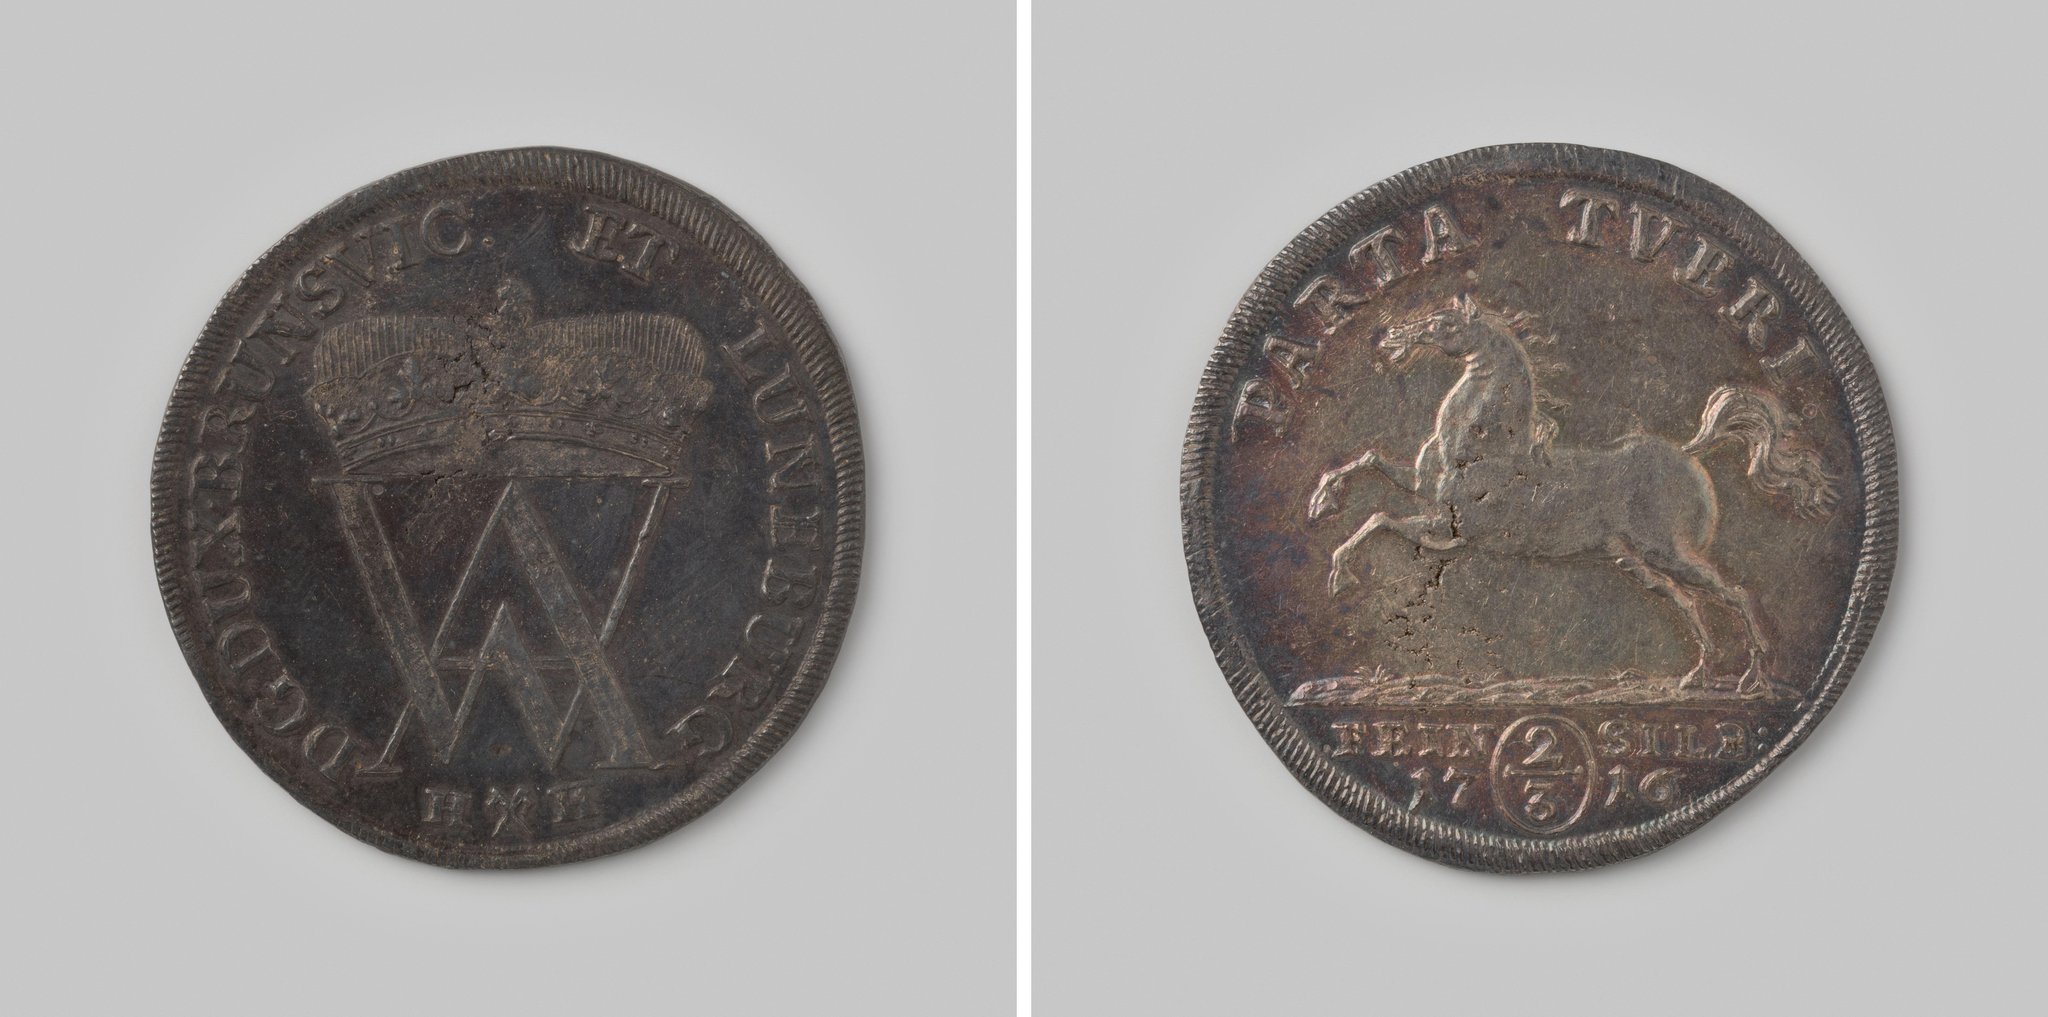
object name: tweederde taler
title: Brunswijk-Wolfenbuttel, August Wilhelm, 2/3 Taler,1716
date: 1716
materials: silver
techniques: striking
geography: clausthal-zellerfeld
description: Zilveren munt. Voorzijde: gekroond monogram van de vorst. Keerzijde: paard in galop naar links. In afsnede waarde-aanduiding en jaartal. Gladde rand.